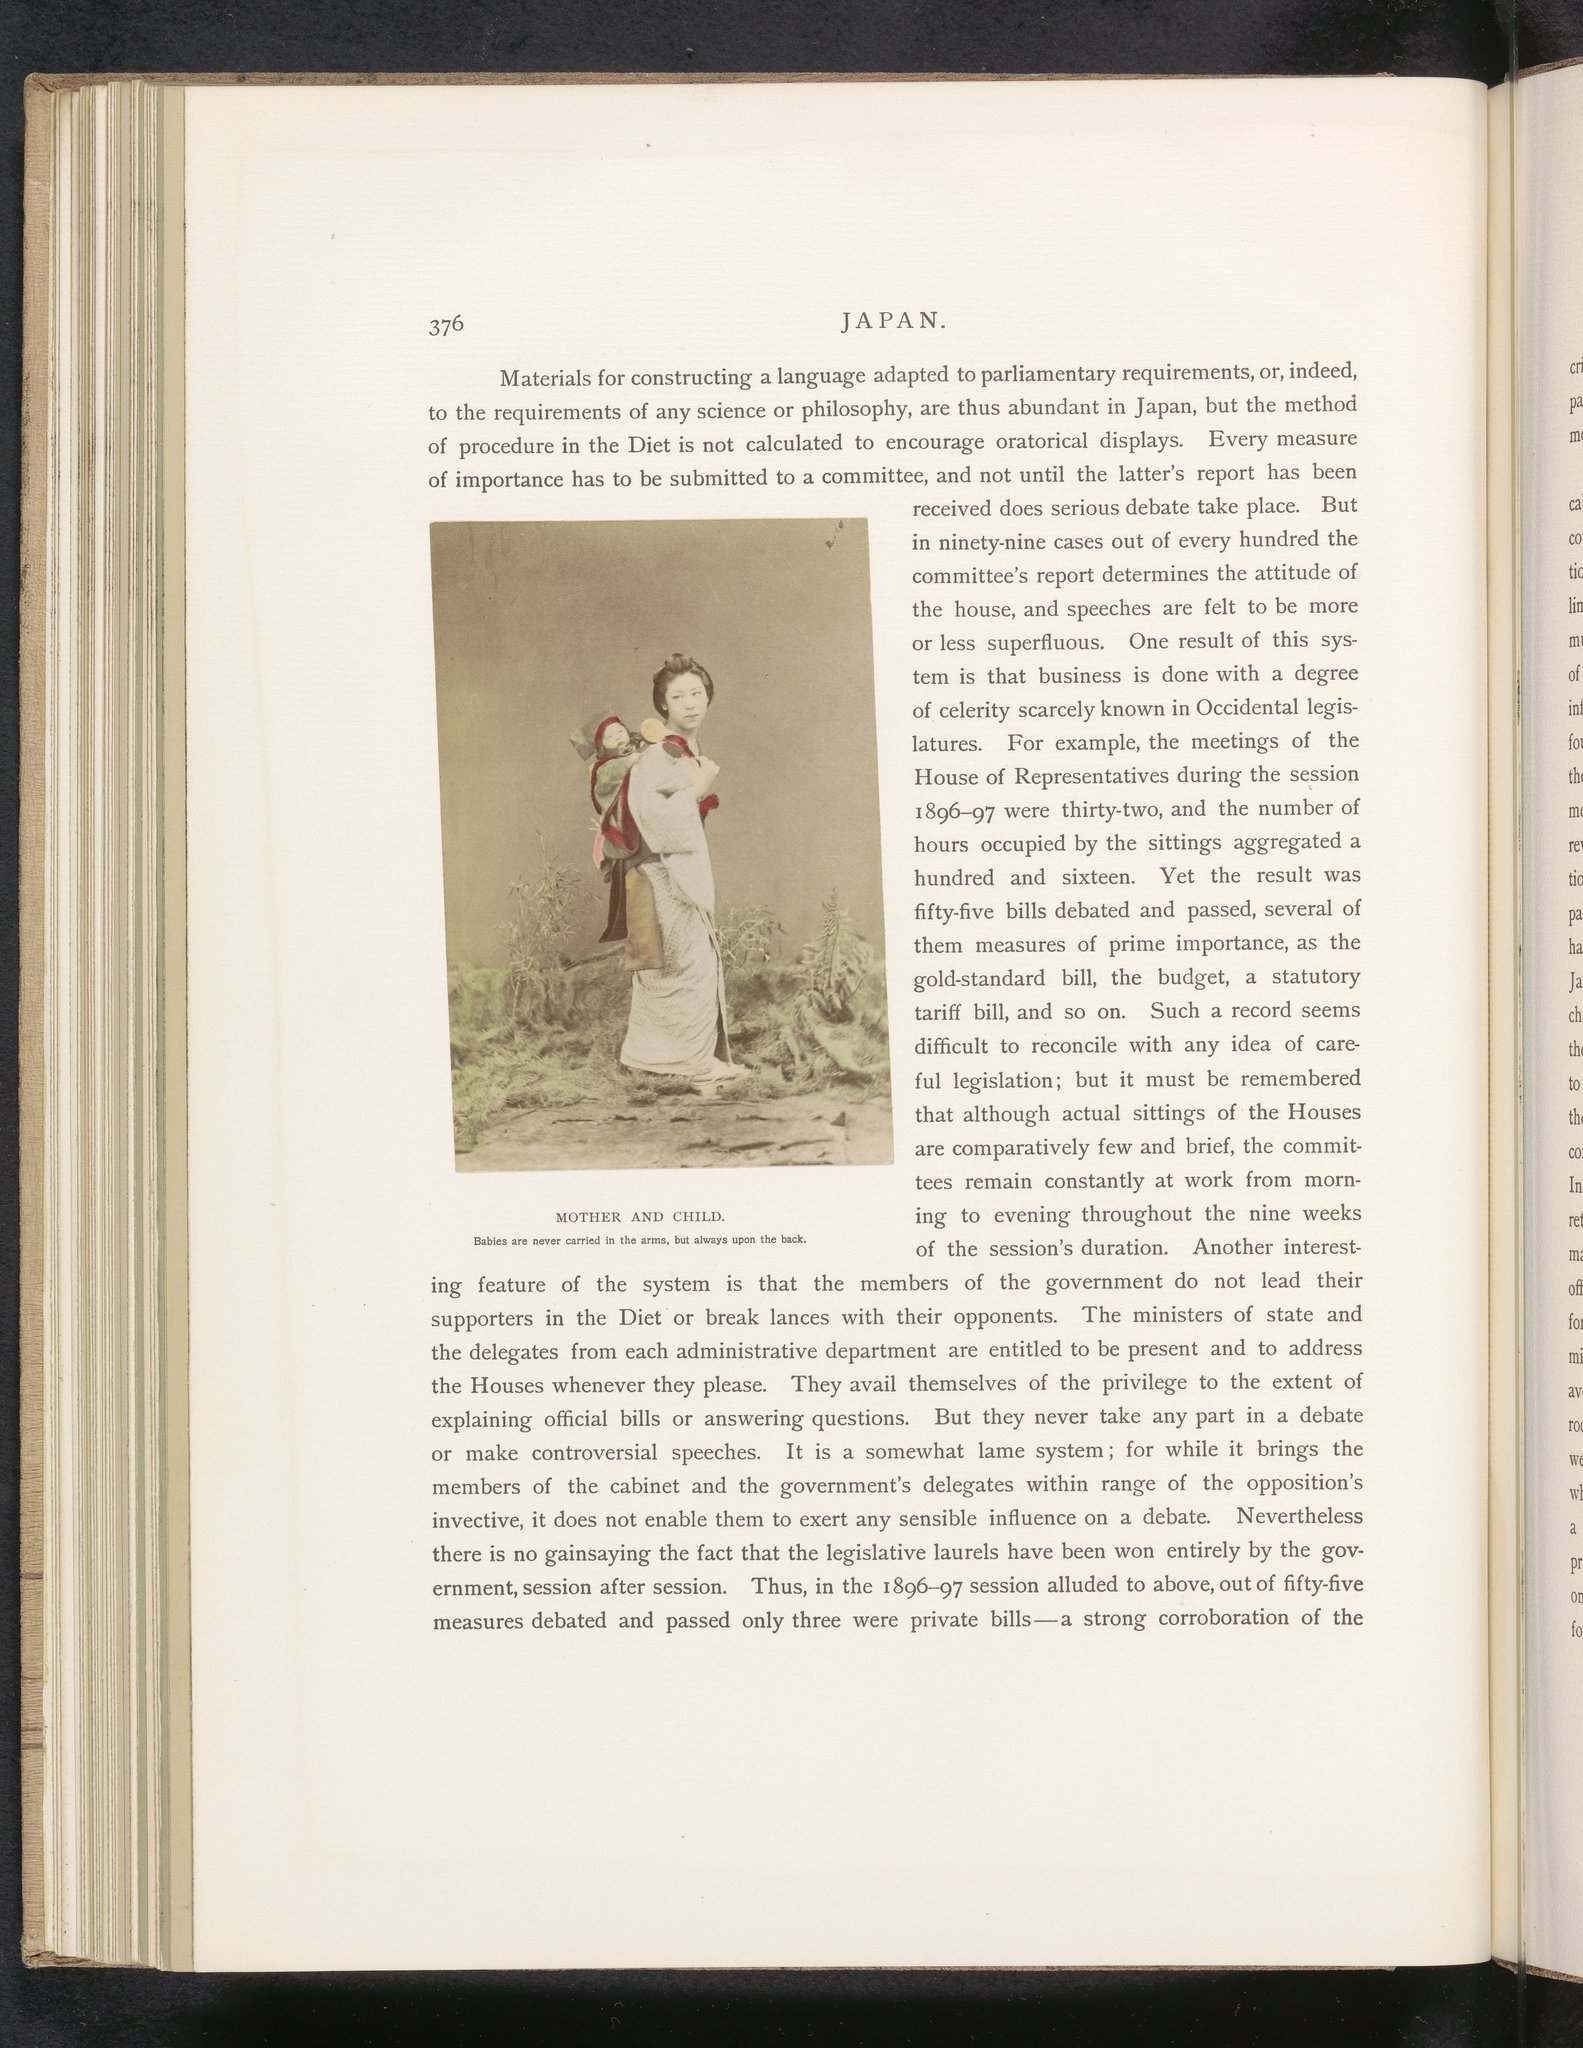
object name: page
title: Mother and child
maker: Anonymous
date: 1888-1898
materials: photographic support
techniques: albumen print, hand coloring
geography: japan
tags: mother and baby or young child, carrying a child on the back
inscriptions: inscription: ‘Babies are never carried in the arms, but always on the back.’